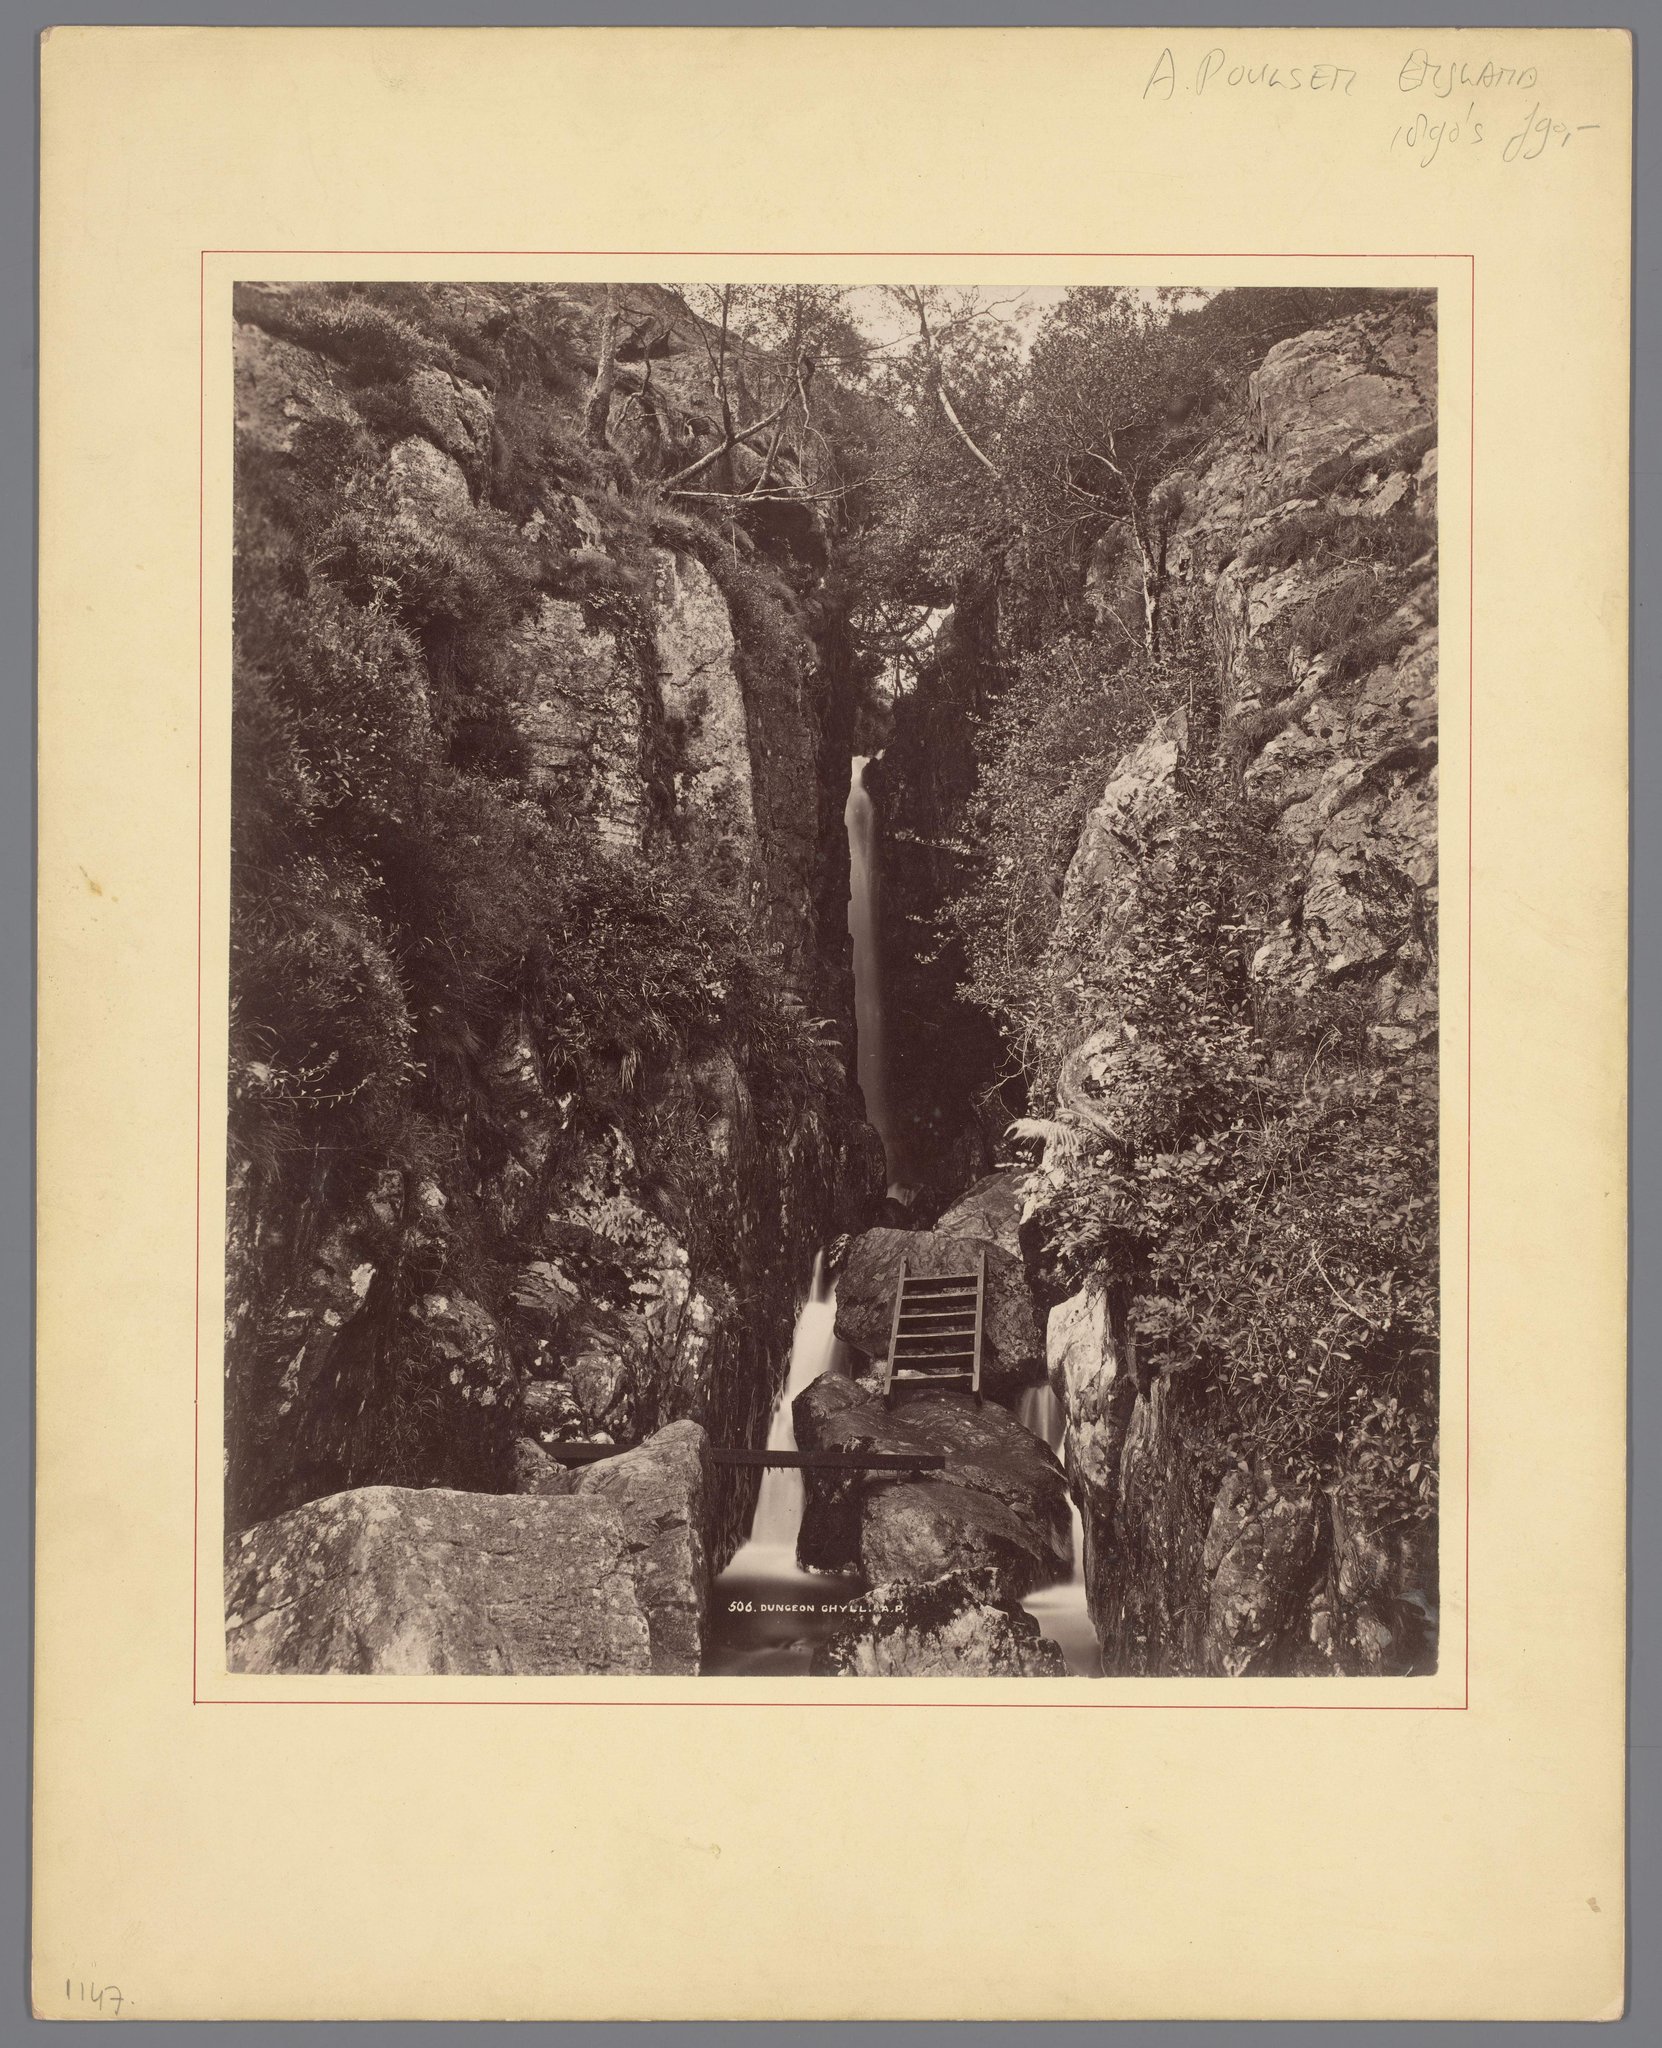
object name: photograph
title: Dungeon Ghyll, Great Langdale valley, Cumbria, Engeland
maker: a. poulsen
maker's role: fotograaf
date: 1885-1910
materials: cardboard, paper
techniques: albumen print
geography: england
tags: england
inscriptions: inscription: ‘Chav. P. Richards//Duke St. Barrow in Furness’, number: ‘1147.’, inscription: ‘Dungeon Ghyll. A.P.’, inscription: ‘A. Poulsen England//1890's ƒ90,-’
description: Dungeon Ghyll is een ravijn. Deze is op de foto te zien, met waterval (bekend onder de naam Dungeon Ghyll Force), en op de stenen langs het water ligt prominent in beeld een ladder.